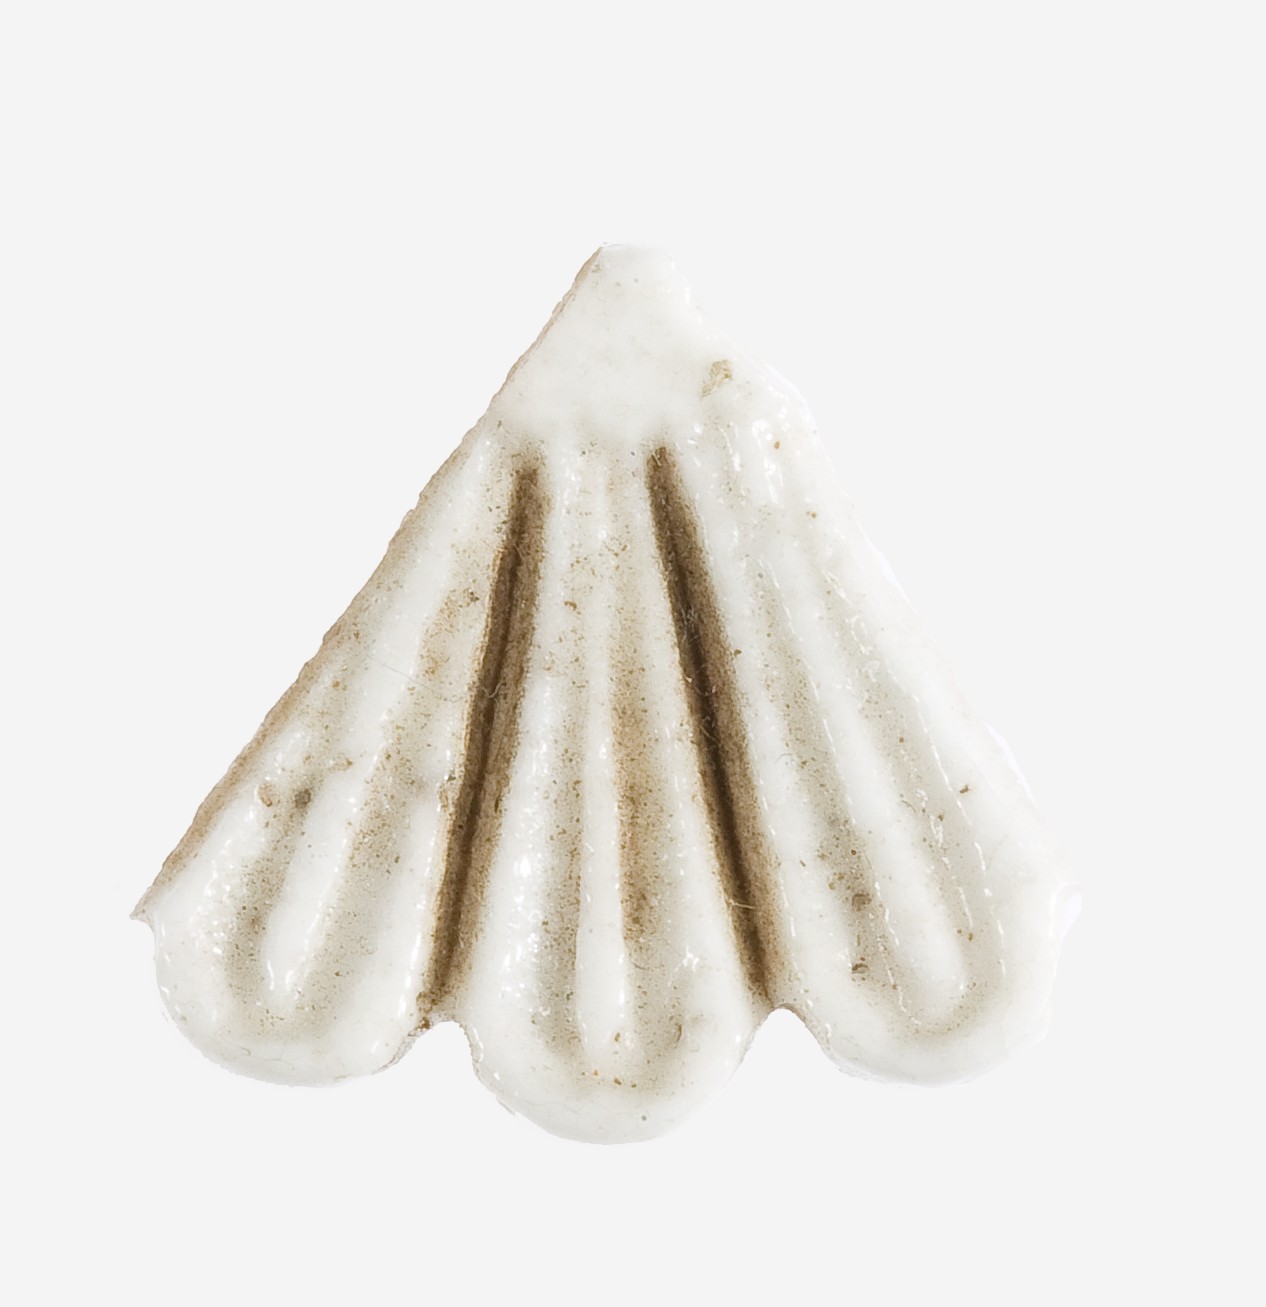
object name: bead, daisy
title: Fragment of a Daisy Bead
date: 1390-1352 BCE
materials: faience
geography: egypt